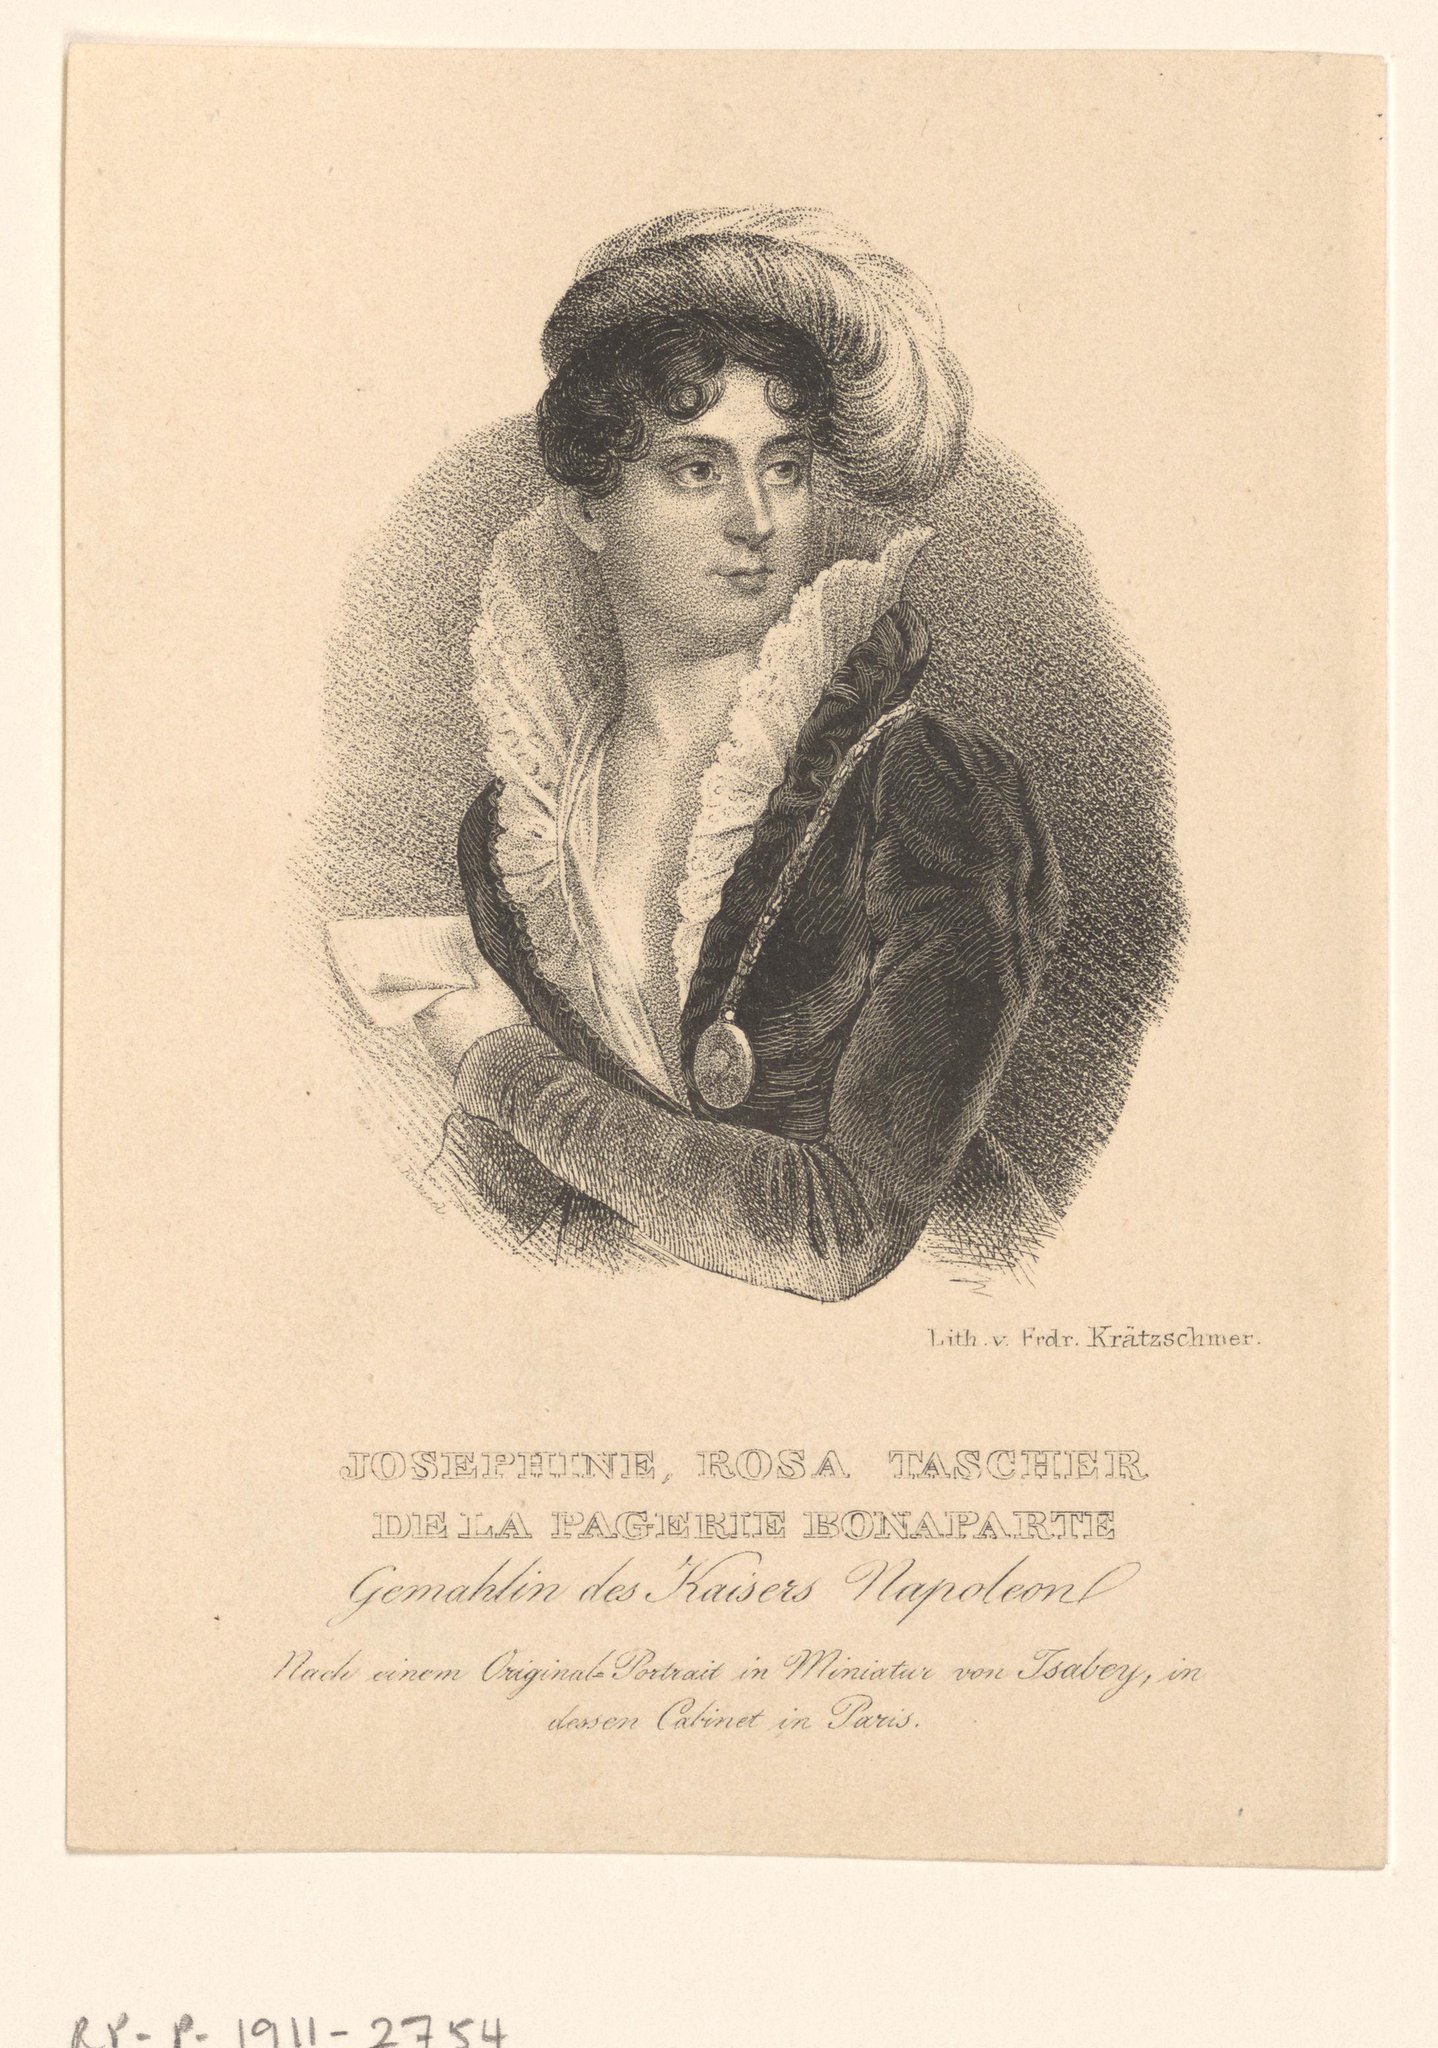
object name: print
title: Portret van Joséphine de Beauharnais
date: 1816-1886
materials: paper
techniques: lithograph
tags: joséphine de beauharnais, historical persons - bb - woman, emperor - bb - female ruler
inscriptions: collector's mark: Lugt 2760, collector's mark: Lugt 2228